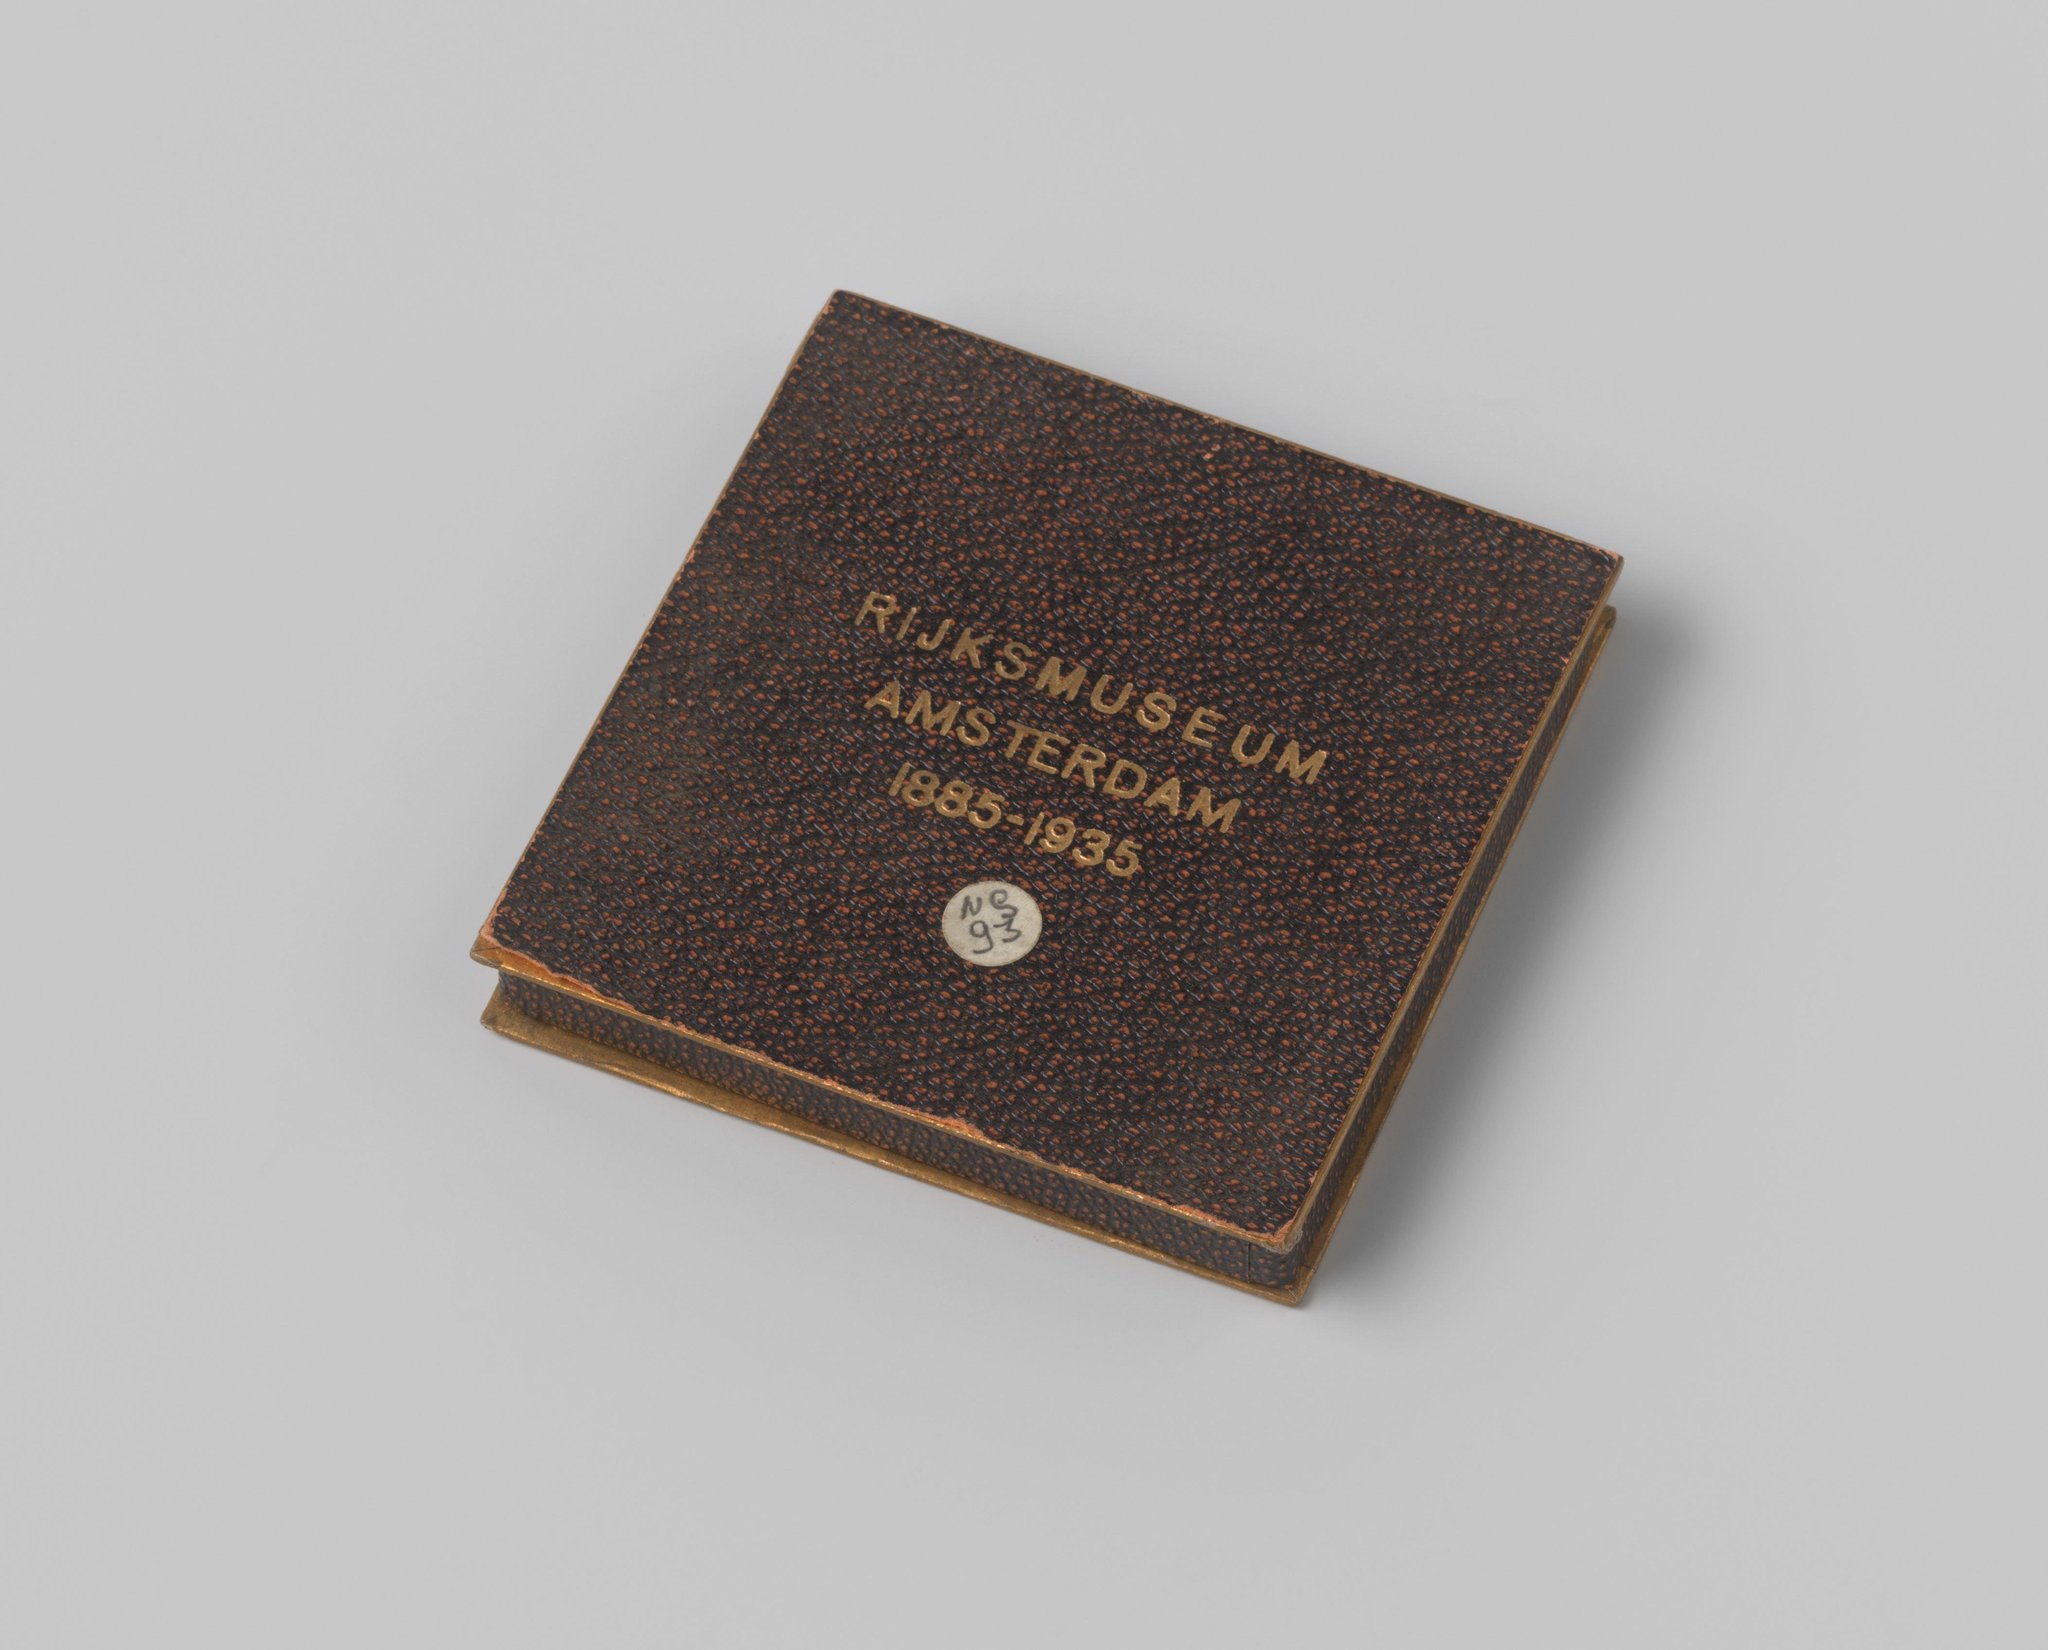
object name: box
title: Doos behorend bij een bronzen penning ter ere van vijfig jaar Rijksmuseum Amsterdam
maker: dirk bus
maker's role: sculptor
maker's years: 1907-1978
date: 1935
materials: cardboard, velvet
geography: netherlands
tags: rijksmuseum amsterdam, amsterdam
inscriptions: date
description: Vierkant doosje met gouden rand behorend bij een bronzen penning. Op de deksel staat de "Rijksmuseum Amsterdam 1885-1935". Binnenzijde doosje is van rood-bruin fluweel.